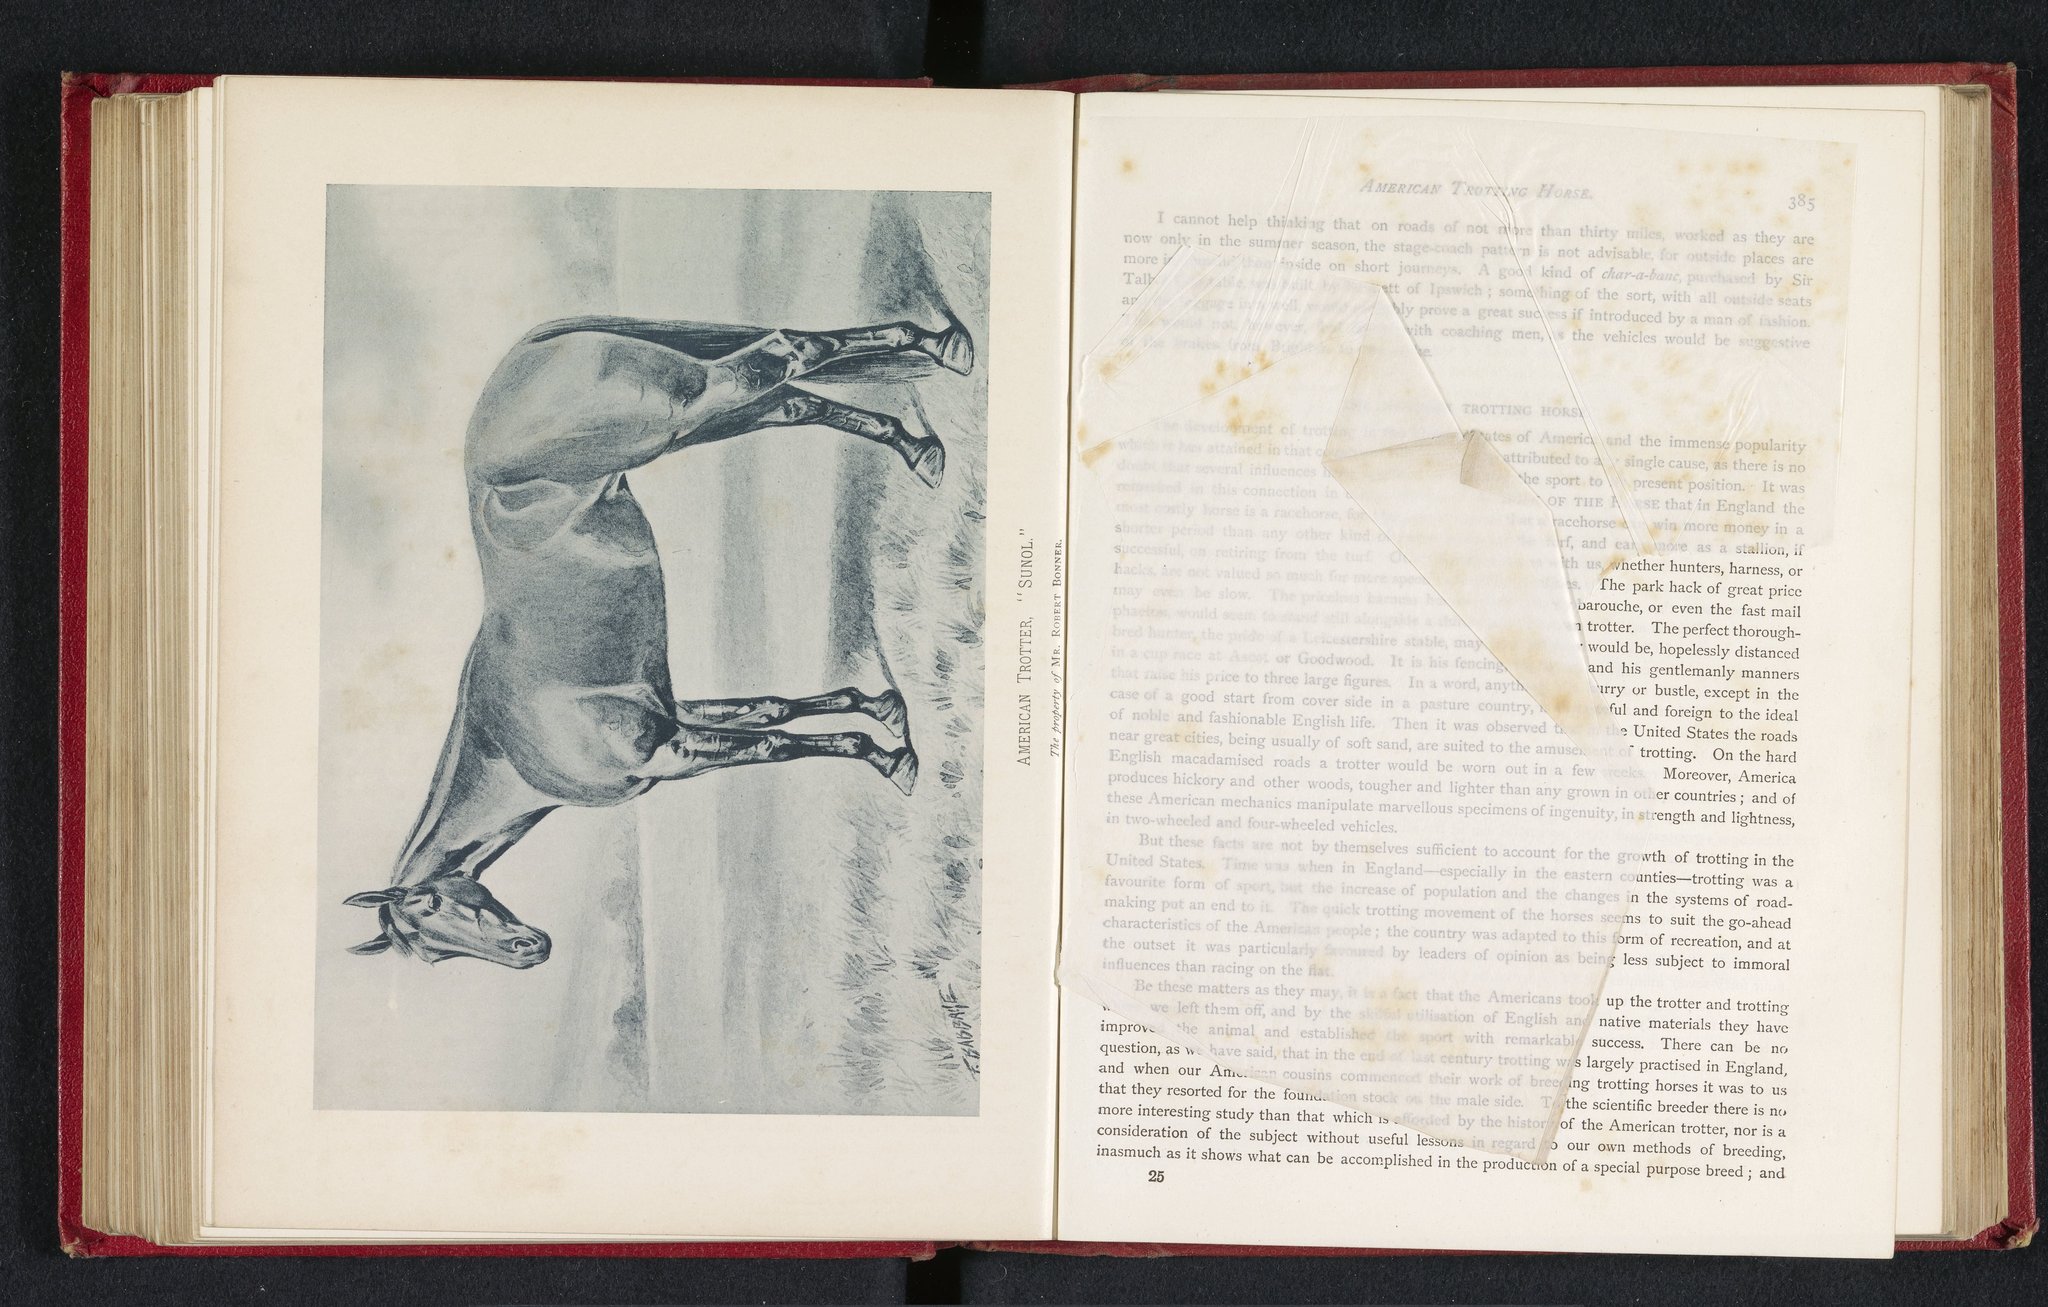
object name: page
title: American Trotter, “Sunol”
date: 1883-1893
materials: paper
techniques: photograph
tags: horse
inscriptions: inscription: ‘The property of Mr. Robert Bonner.’